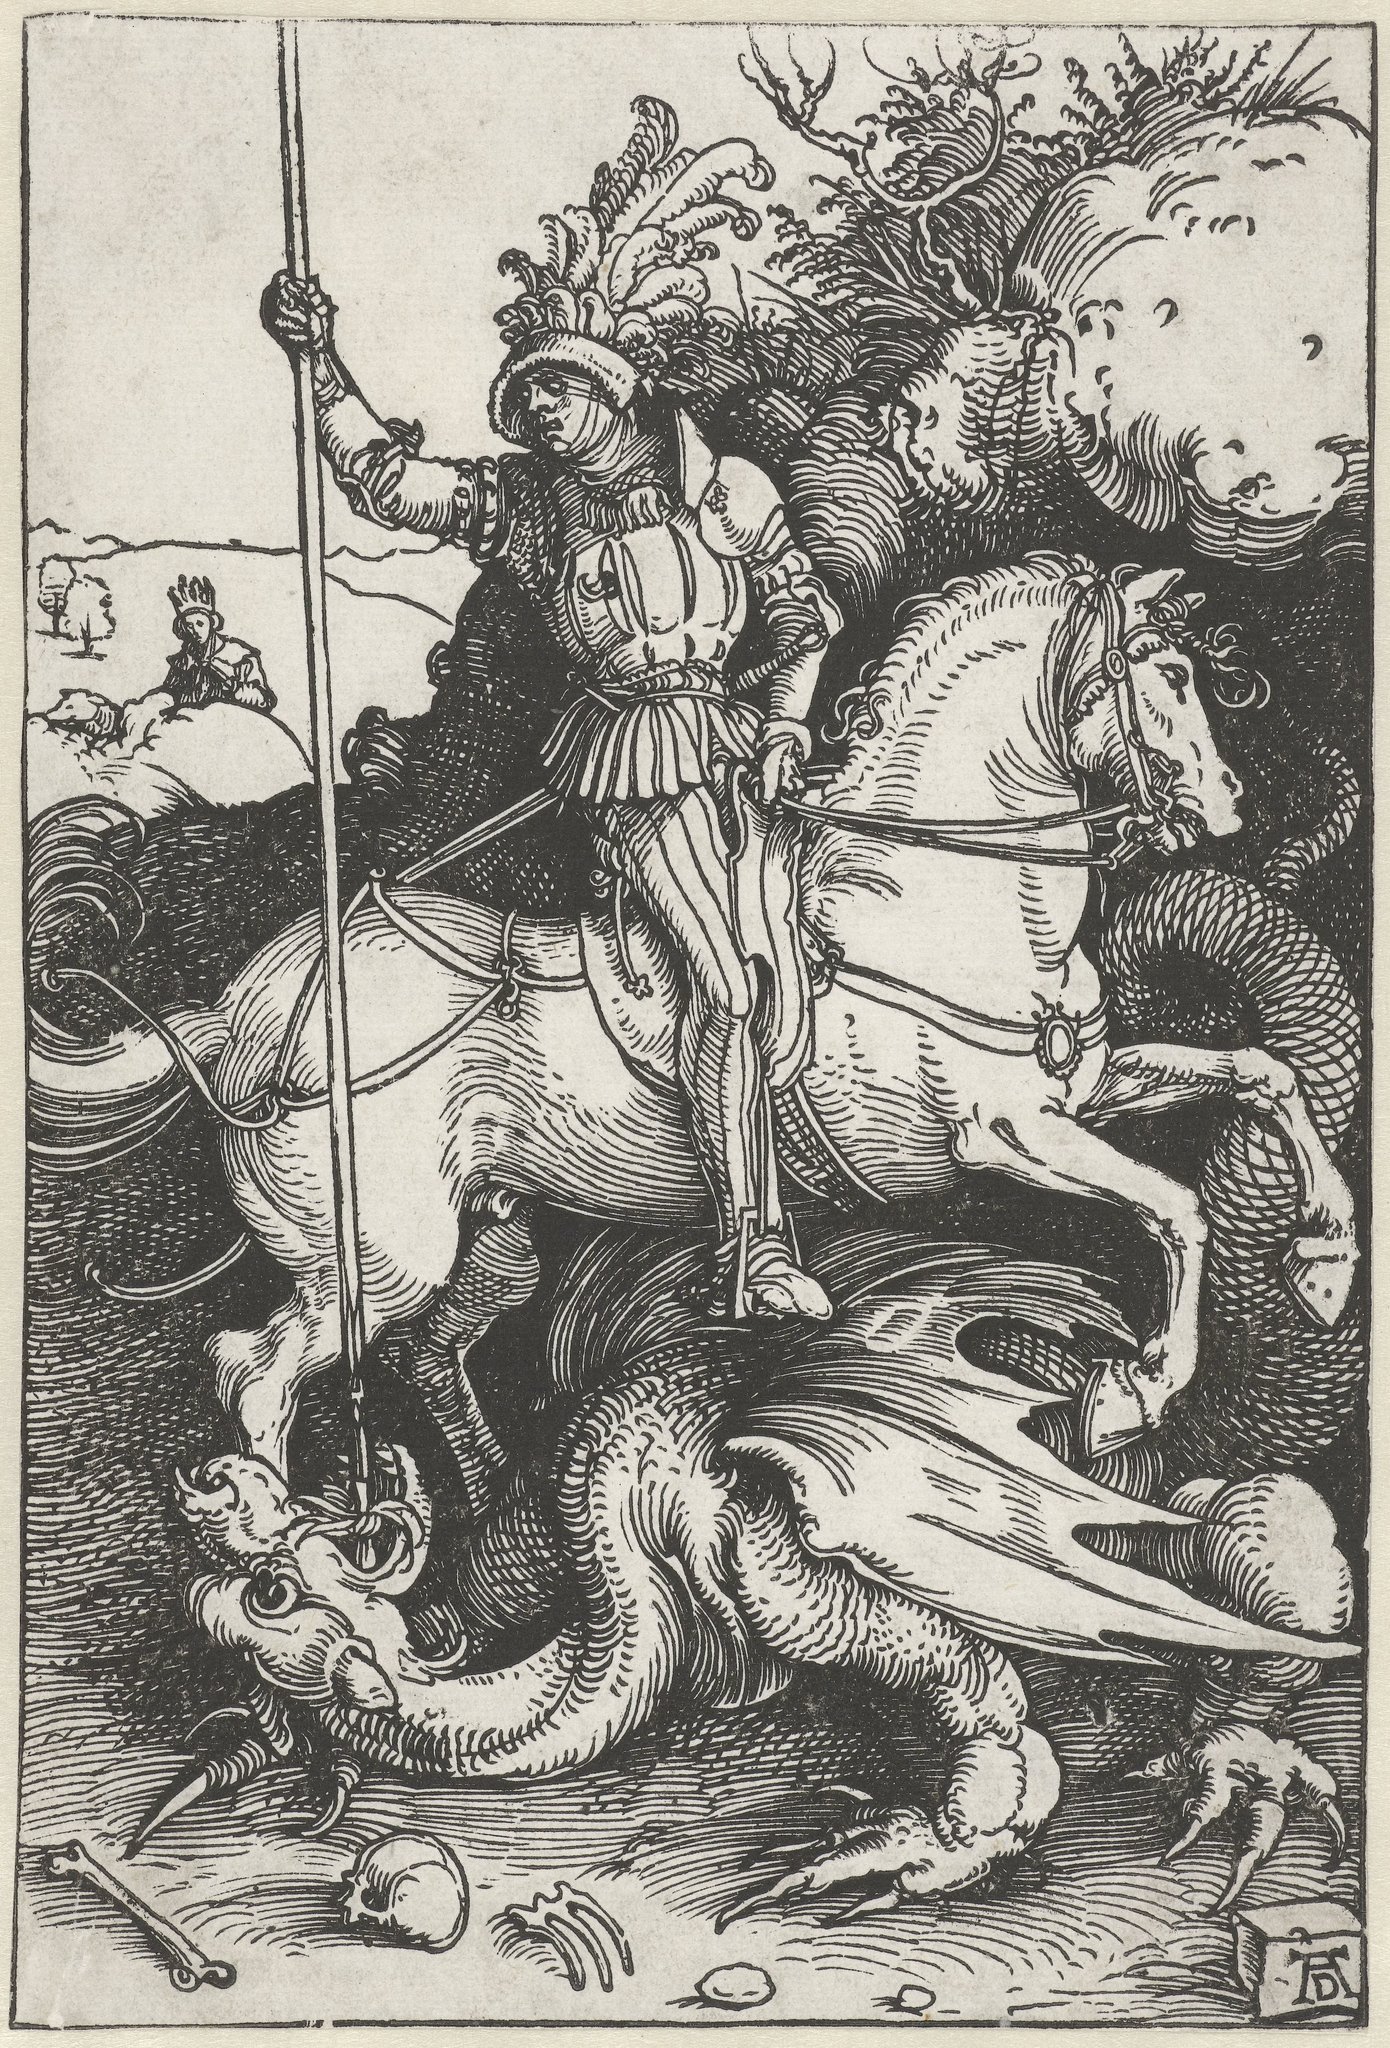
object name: print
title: Saint George Slaying the Dragon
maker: albrecht dürer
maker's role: draughtsman, painter, print maker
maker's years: 1471-1528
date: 1504-1505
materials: paper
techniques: woodcut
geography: nuremberg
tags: st. george and the dragon: dressed in armour and mounted on a (white) horse he brandishes his sword (his lance lies already broken on the ground); the princess nearby may be shown praying or fleeing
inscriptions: collector's mark: Lugt 240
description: The influence exerted by the emerging Renaissance art affected the depiction of Saint George. If the saint was usually represented as a knight in armour at the end of the 15th century, his costume took on classic Roman features in the 16th century. This is also clear to see in the ceremonial chain: around George’s waist is a classic lappet, or apron.